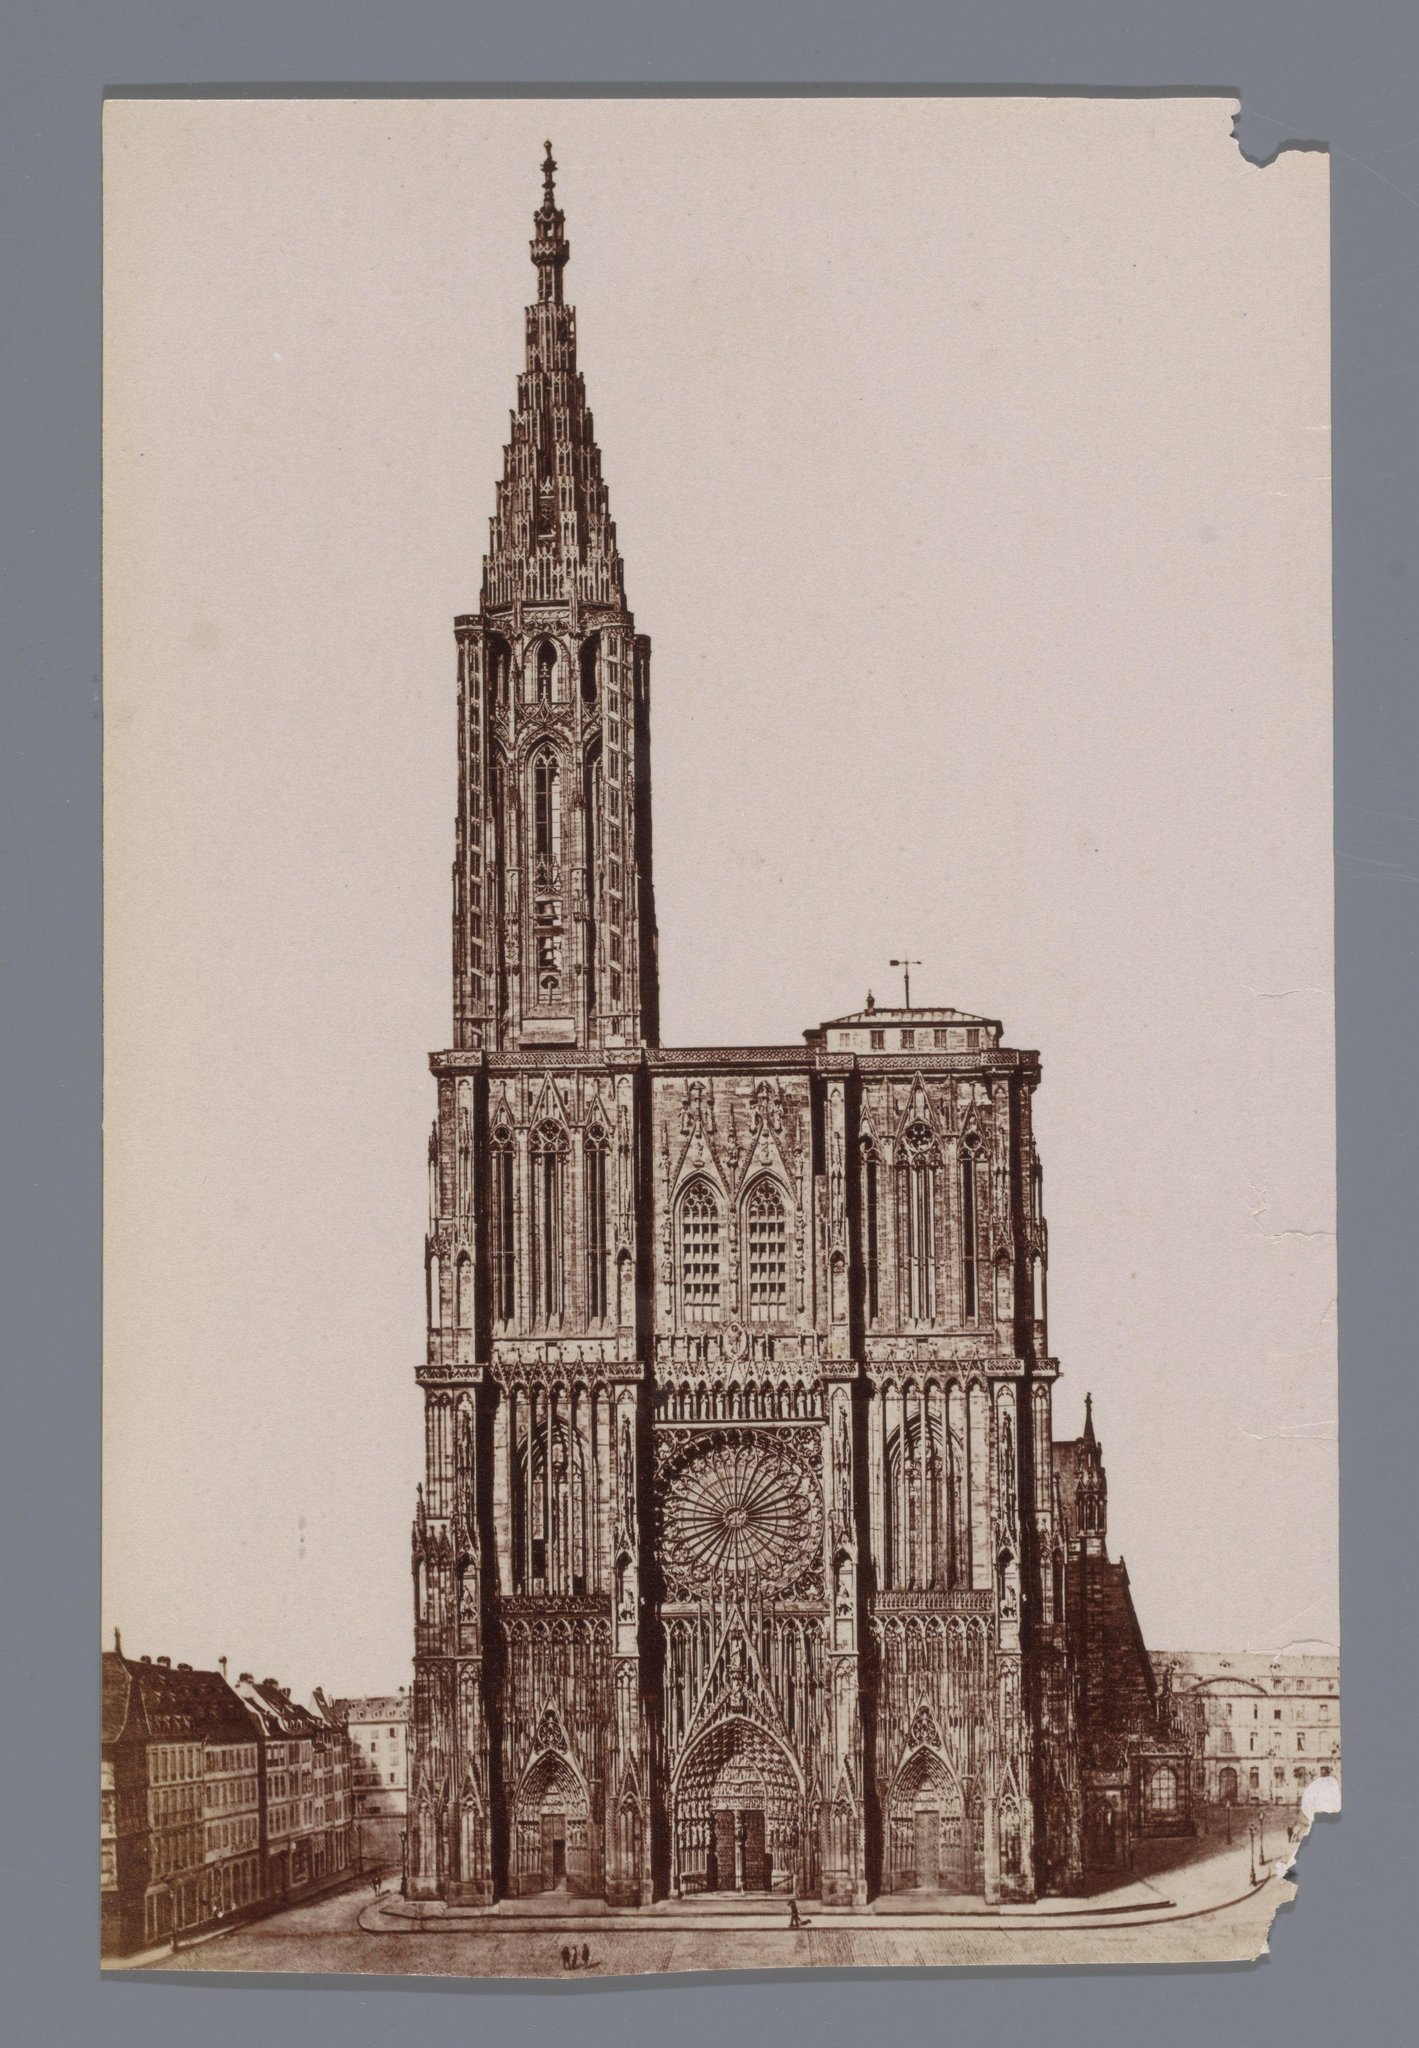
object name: reproduction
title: Fotoreproductie van een ontwerp van de kathedraal van Straatsburg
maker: Anonymous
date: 1860-1890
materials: paper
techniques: albumen print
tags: church (exterior)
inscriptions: inscription: ‘Straatsburg’, collector's mark: ‘Vosmaer’